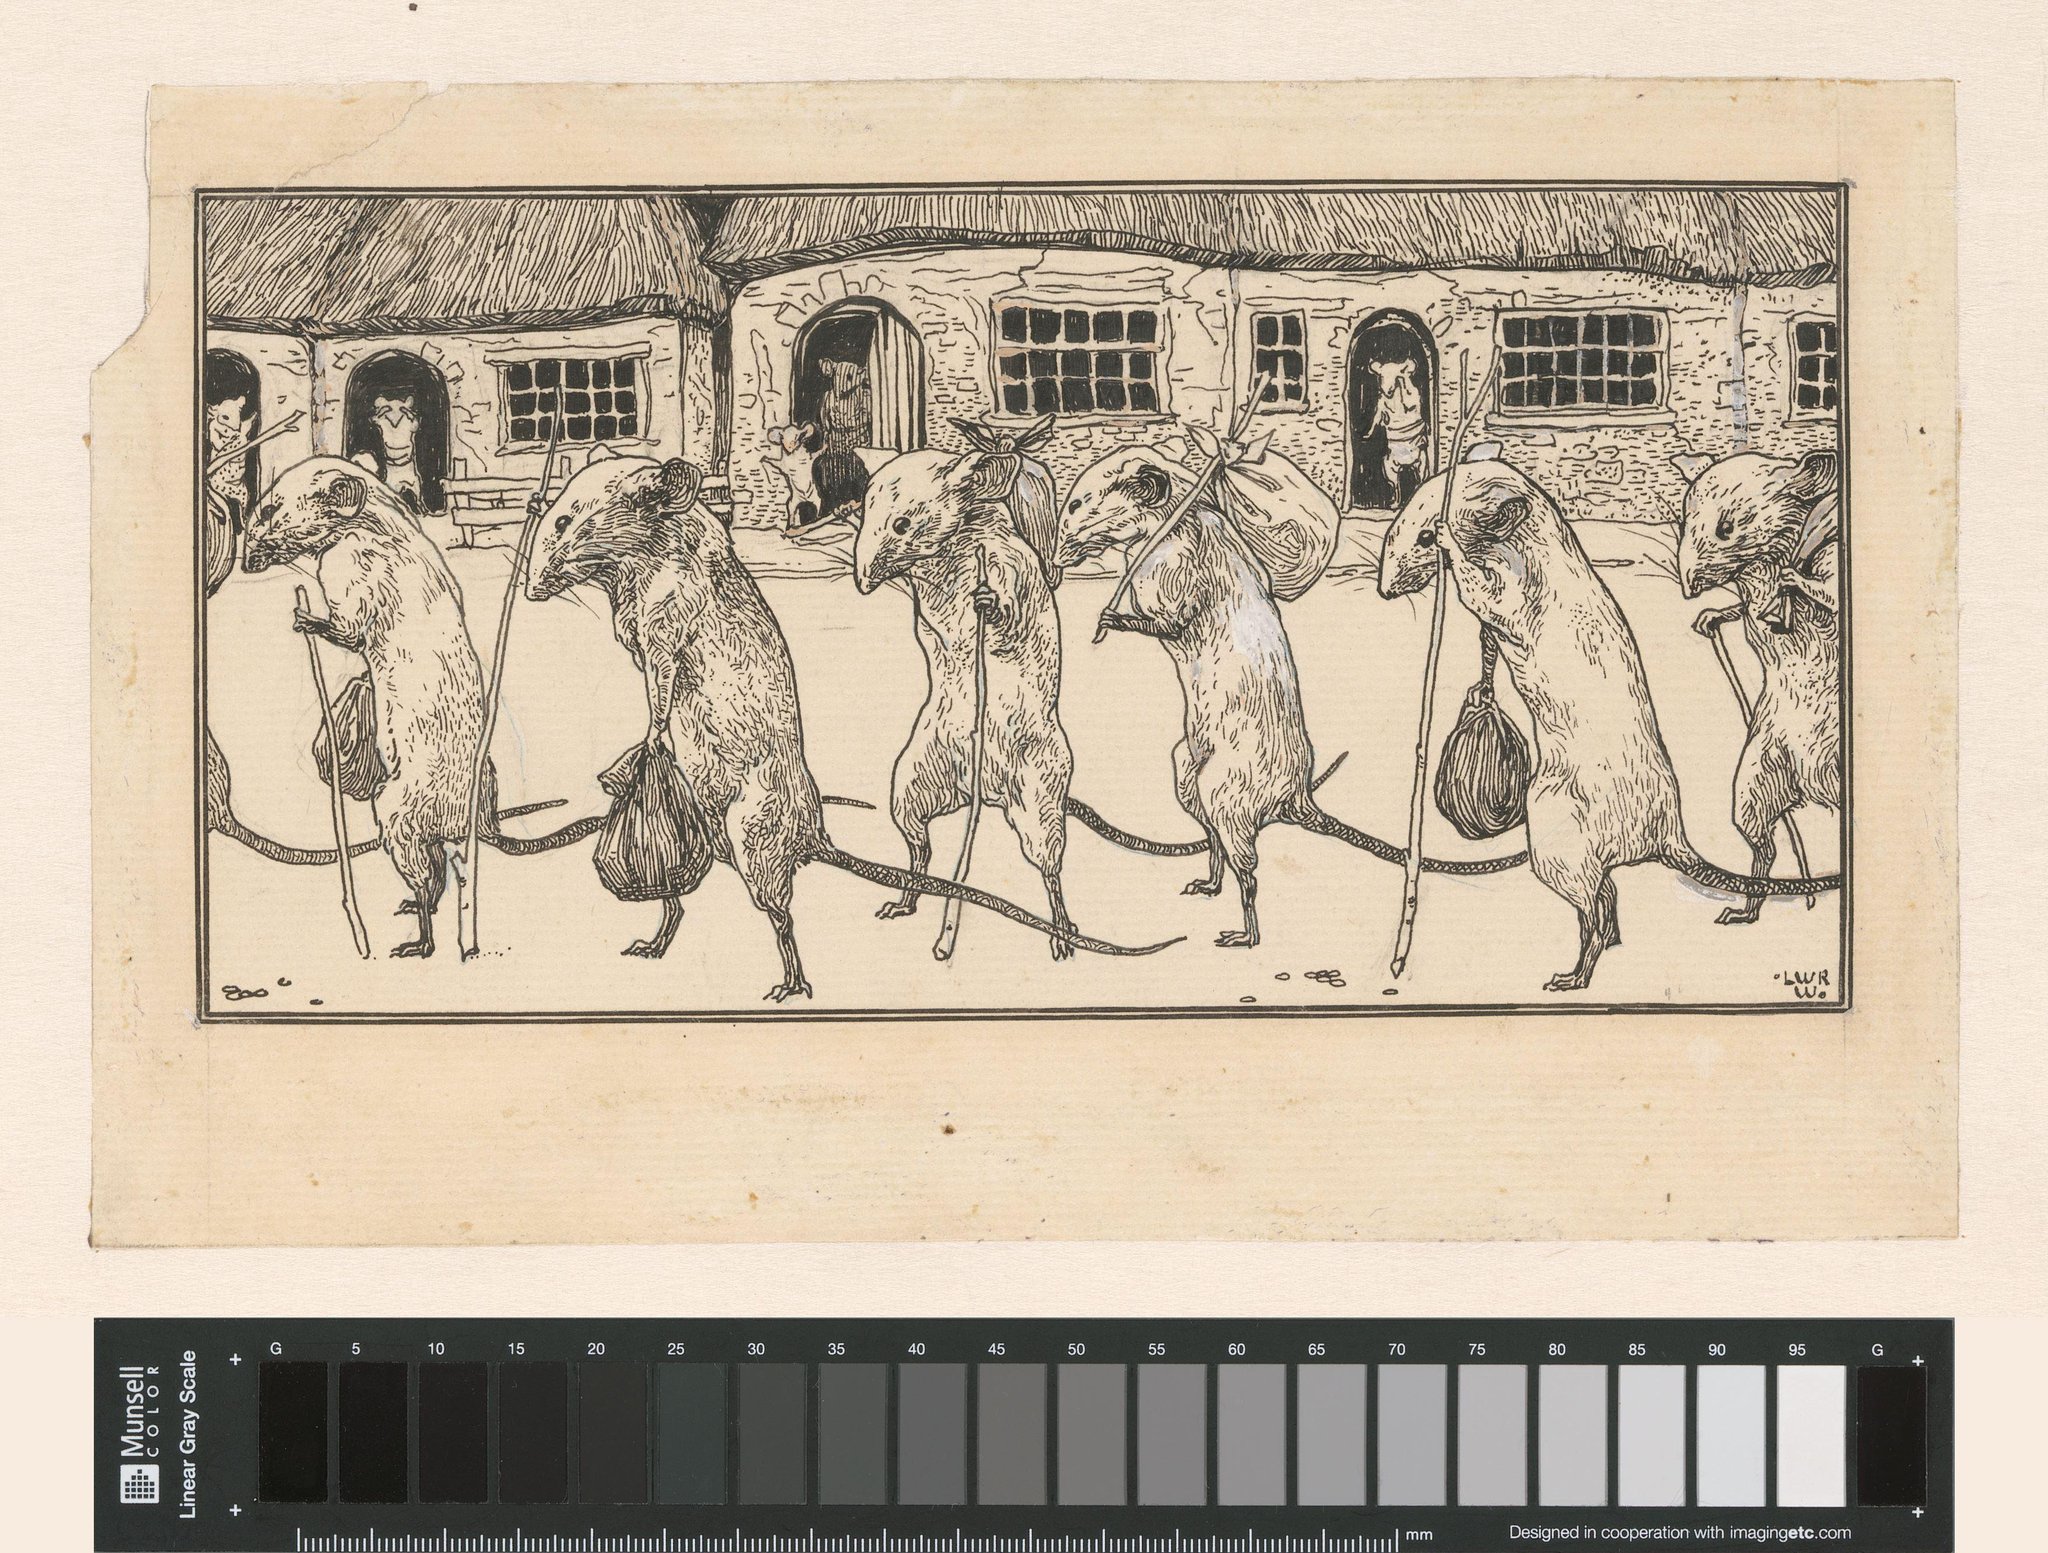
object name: boekillustratie ontwerp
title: Optocht van muizen met wandelstokken en buidels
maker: willem wenckebach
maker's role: designer, draughtsman, painter, print maker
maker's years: 1860-1937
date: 1894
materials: paint, ink, paper, pencil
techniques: brush, pen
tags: rodents: mouse, walking-stick, staff, street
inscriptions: number: ‘no 167’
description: De muizen, die uit jagen zijn geweest, lopen achter elkaar met gebogen koppen door een straat. Ze zijn droevig omdat één van de jagers is opgegeten door een kat. In de deuropeningen van de huizen in de straat staan muizen in hun ogen te wrijven. Ontwerp voor 'Het muizengezin en wat er verder voor viel', het vijfde hoofdstuk van de publicatie.